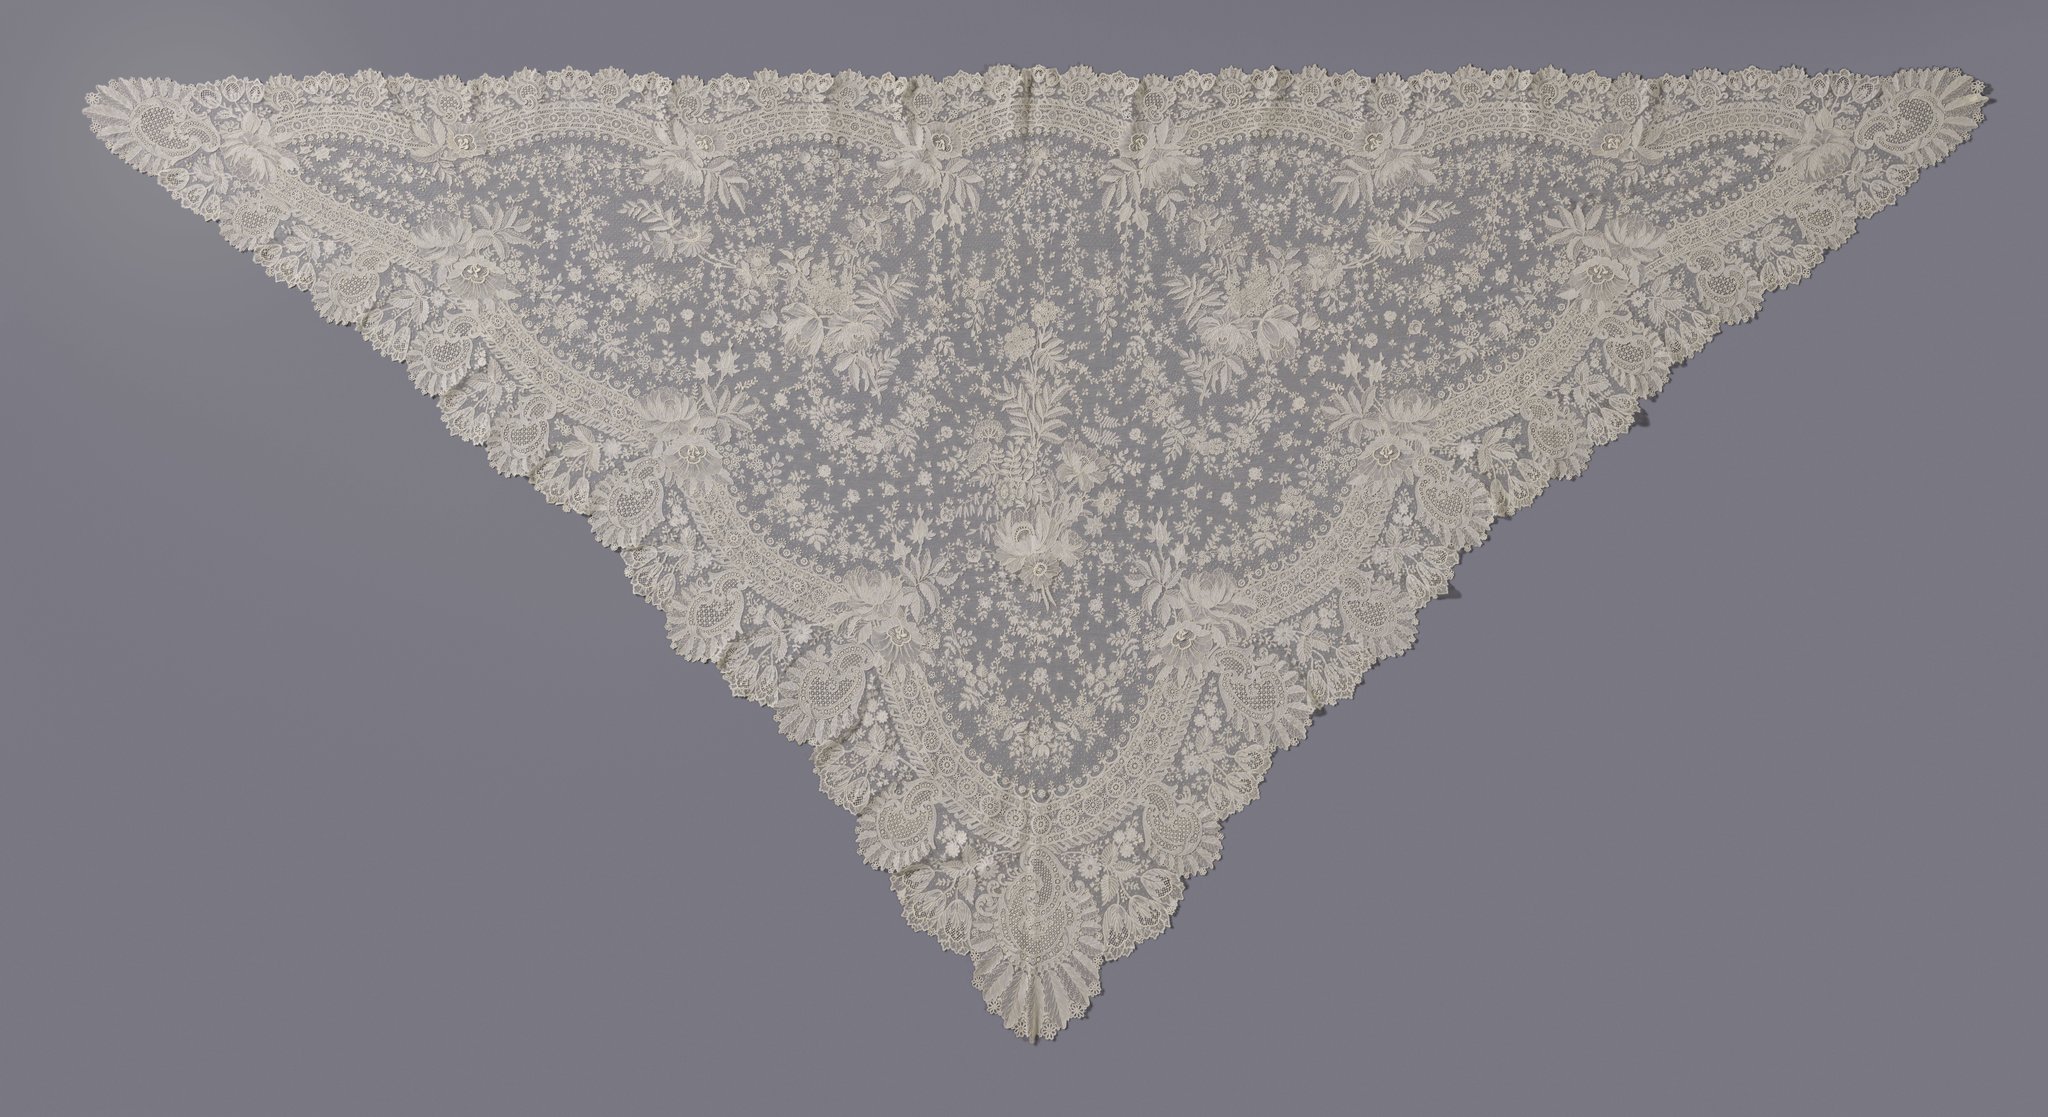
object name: scarf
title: Driekant shawl van naaldkant met lelies en papavers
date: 1894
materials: linen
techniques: lace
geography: brussels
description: Sjaal van naturelkleurige gemengde kant: Brusselse kant. Driehoekig model. Langs de drie zijden loopt een brede, golvende lijst, omgeven door een rand van beurtelings kelkbloemen en asymmetrische medaillons van C-voluten; de laatste nemen in grootte toe tot in de punt van het rugstuk. De lijst bestaat uit vijf banen, waarvan de middelste bezet is met grote raderen. Op de golftoppen staan boeketten van een zeer grote lelie en een papaver. In het veld staan drie boeketten, de middelste, grootste, is samengesteld uit papavers, schermbloemen en spirea, de buitenste bevatten een papaver en seringen. Het fond is bezaaid met fijne slingertjes (kloskant), die een met moesjes bezaaid randgedeelte begrenzen. Talrijke bloemlaadjes en blaadjes zijn door de nerf verdeeld in een fel wit en een wazig fond. Point de gaze de Bruxelles.